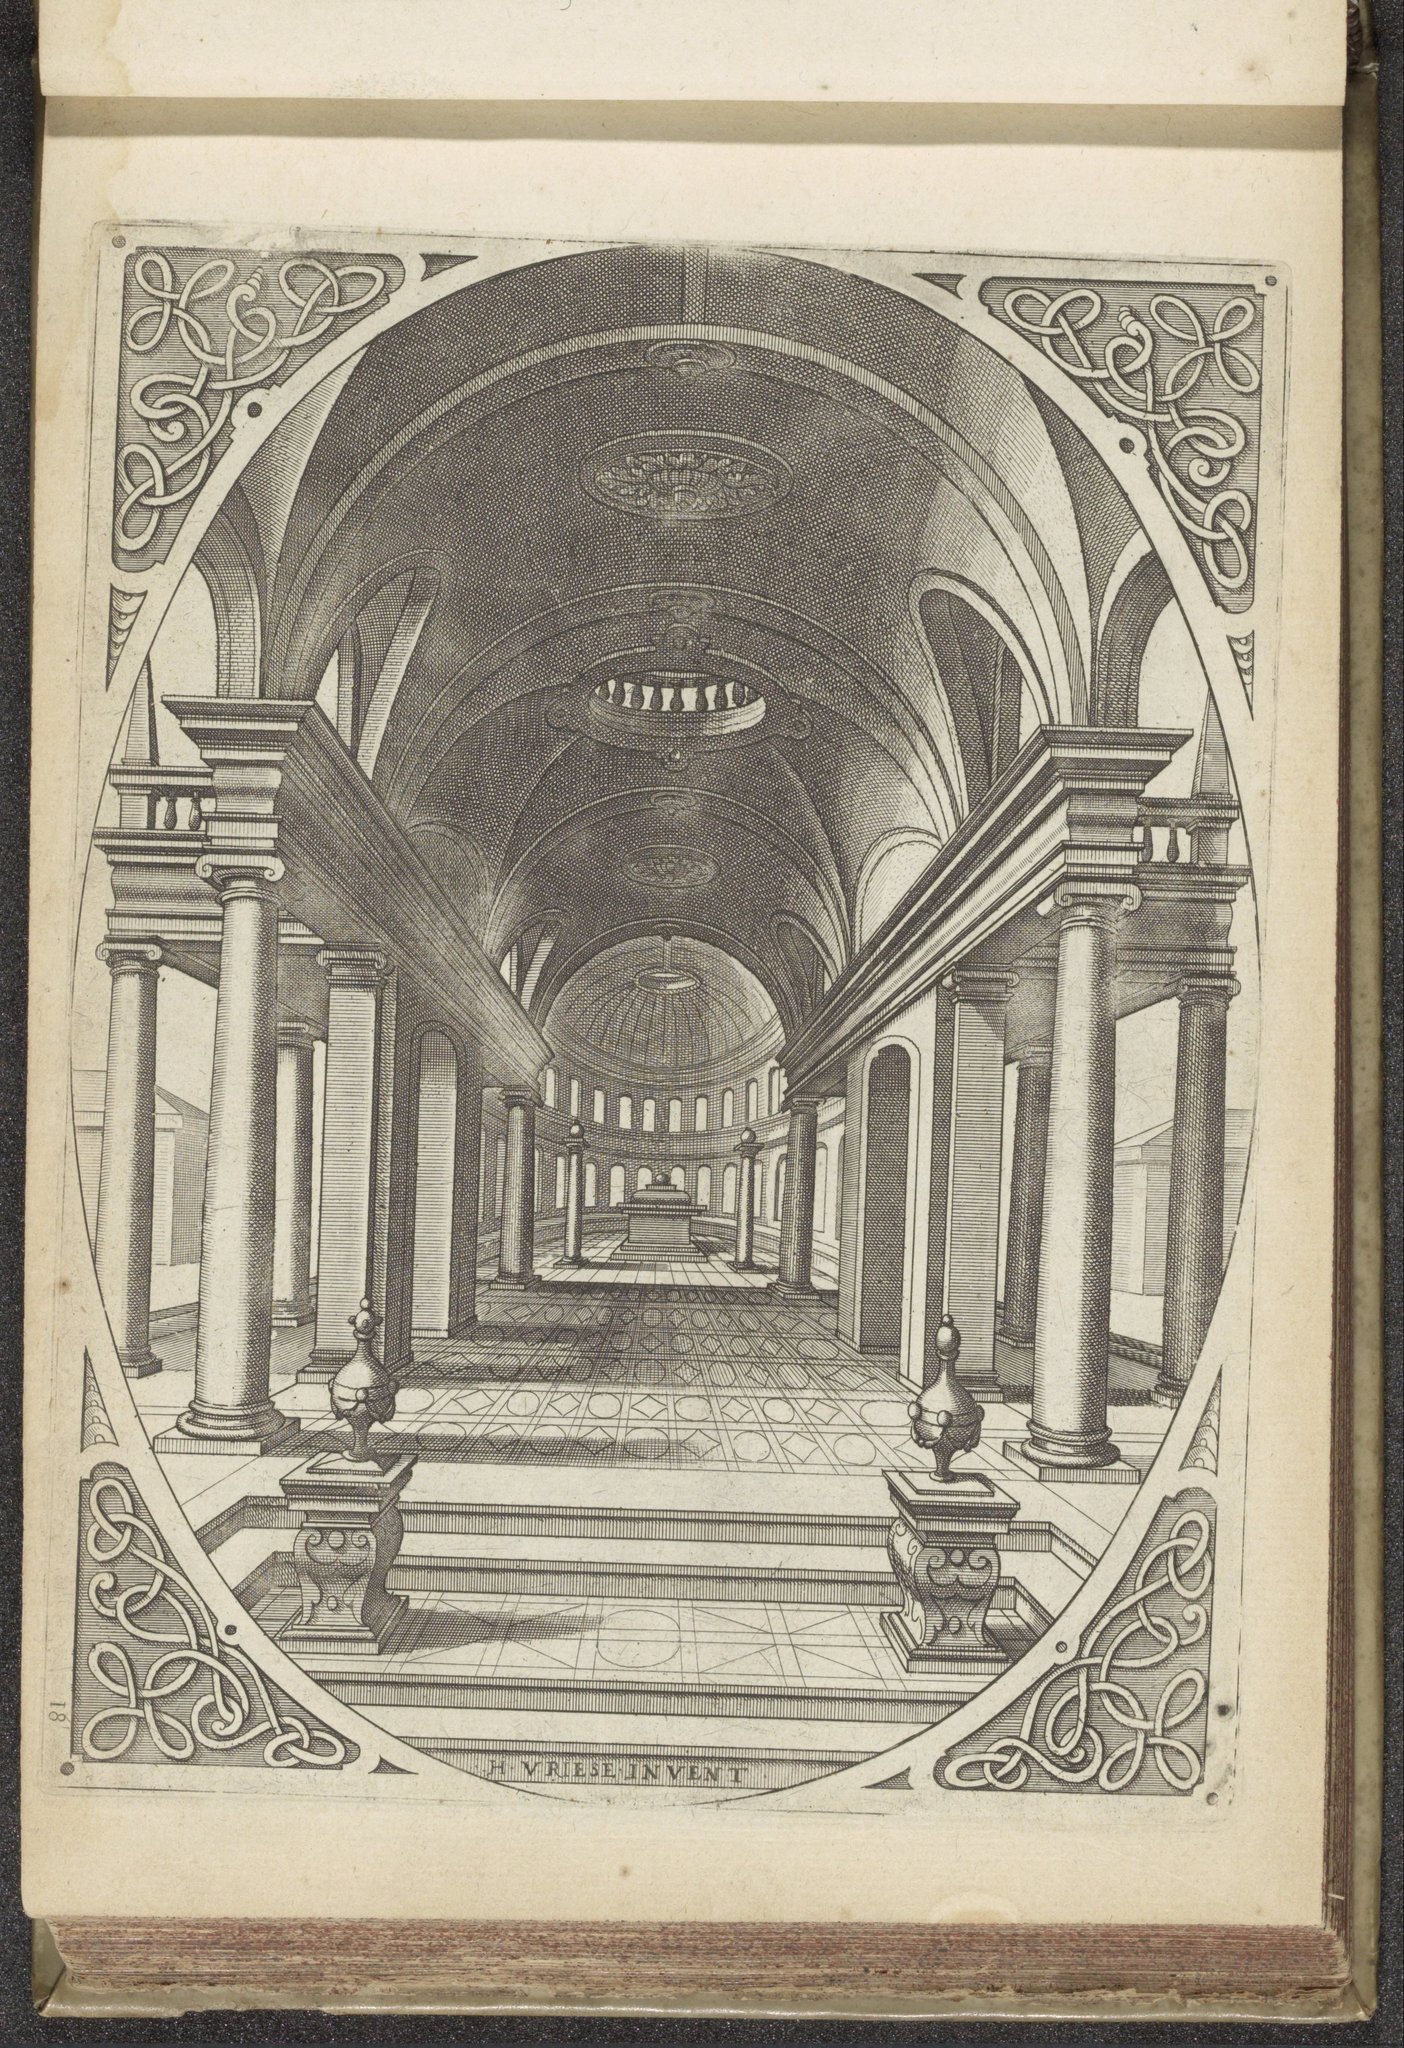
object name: print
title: Variae Architecturae formae (...)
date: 1560-1562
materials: paper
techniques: etching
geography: antwerp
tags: architectural representations in general, parts of church interior: nave, parts of church interior: choir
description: Gezicht in het schip en het koor van een kerk. In de hoeken in elkaar gevlochten banden. Deze prent maakt deel uit van een album.